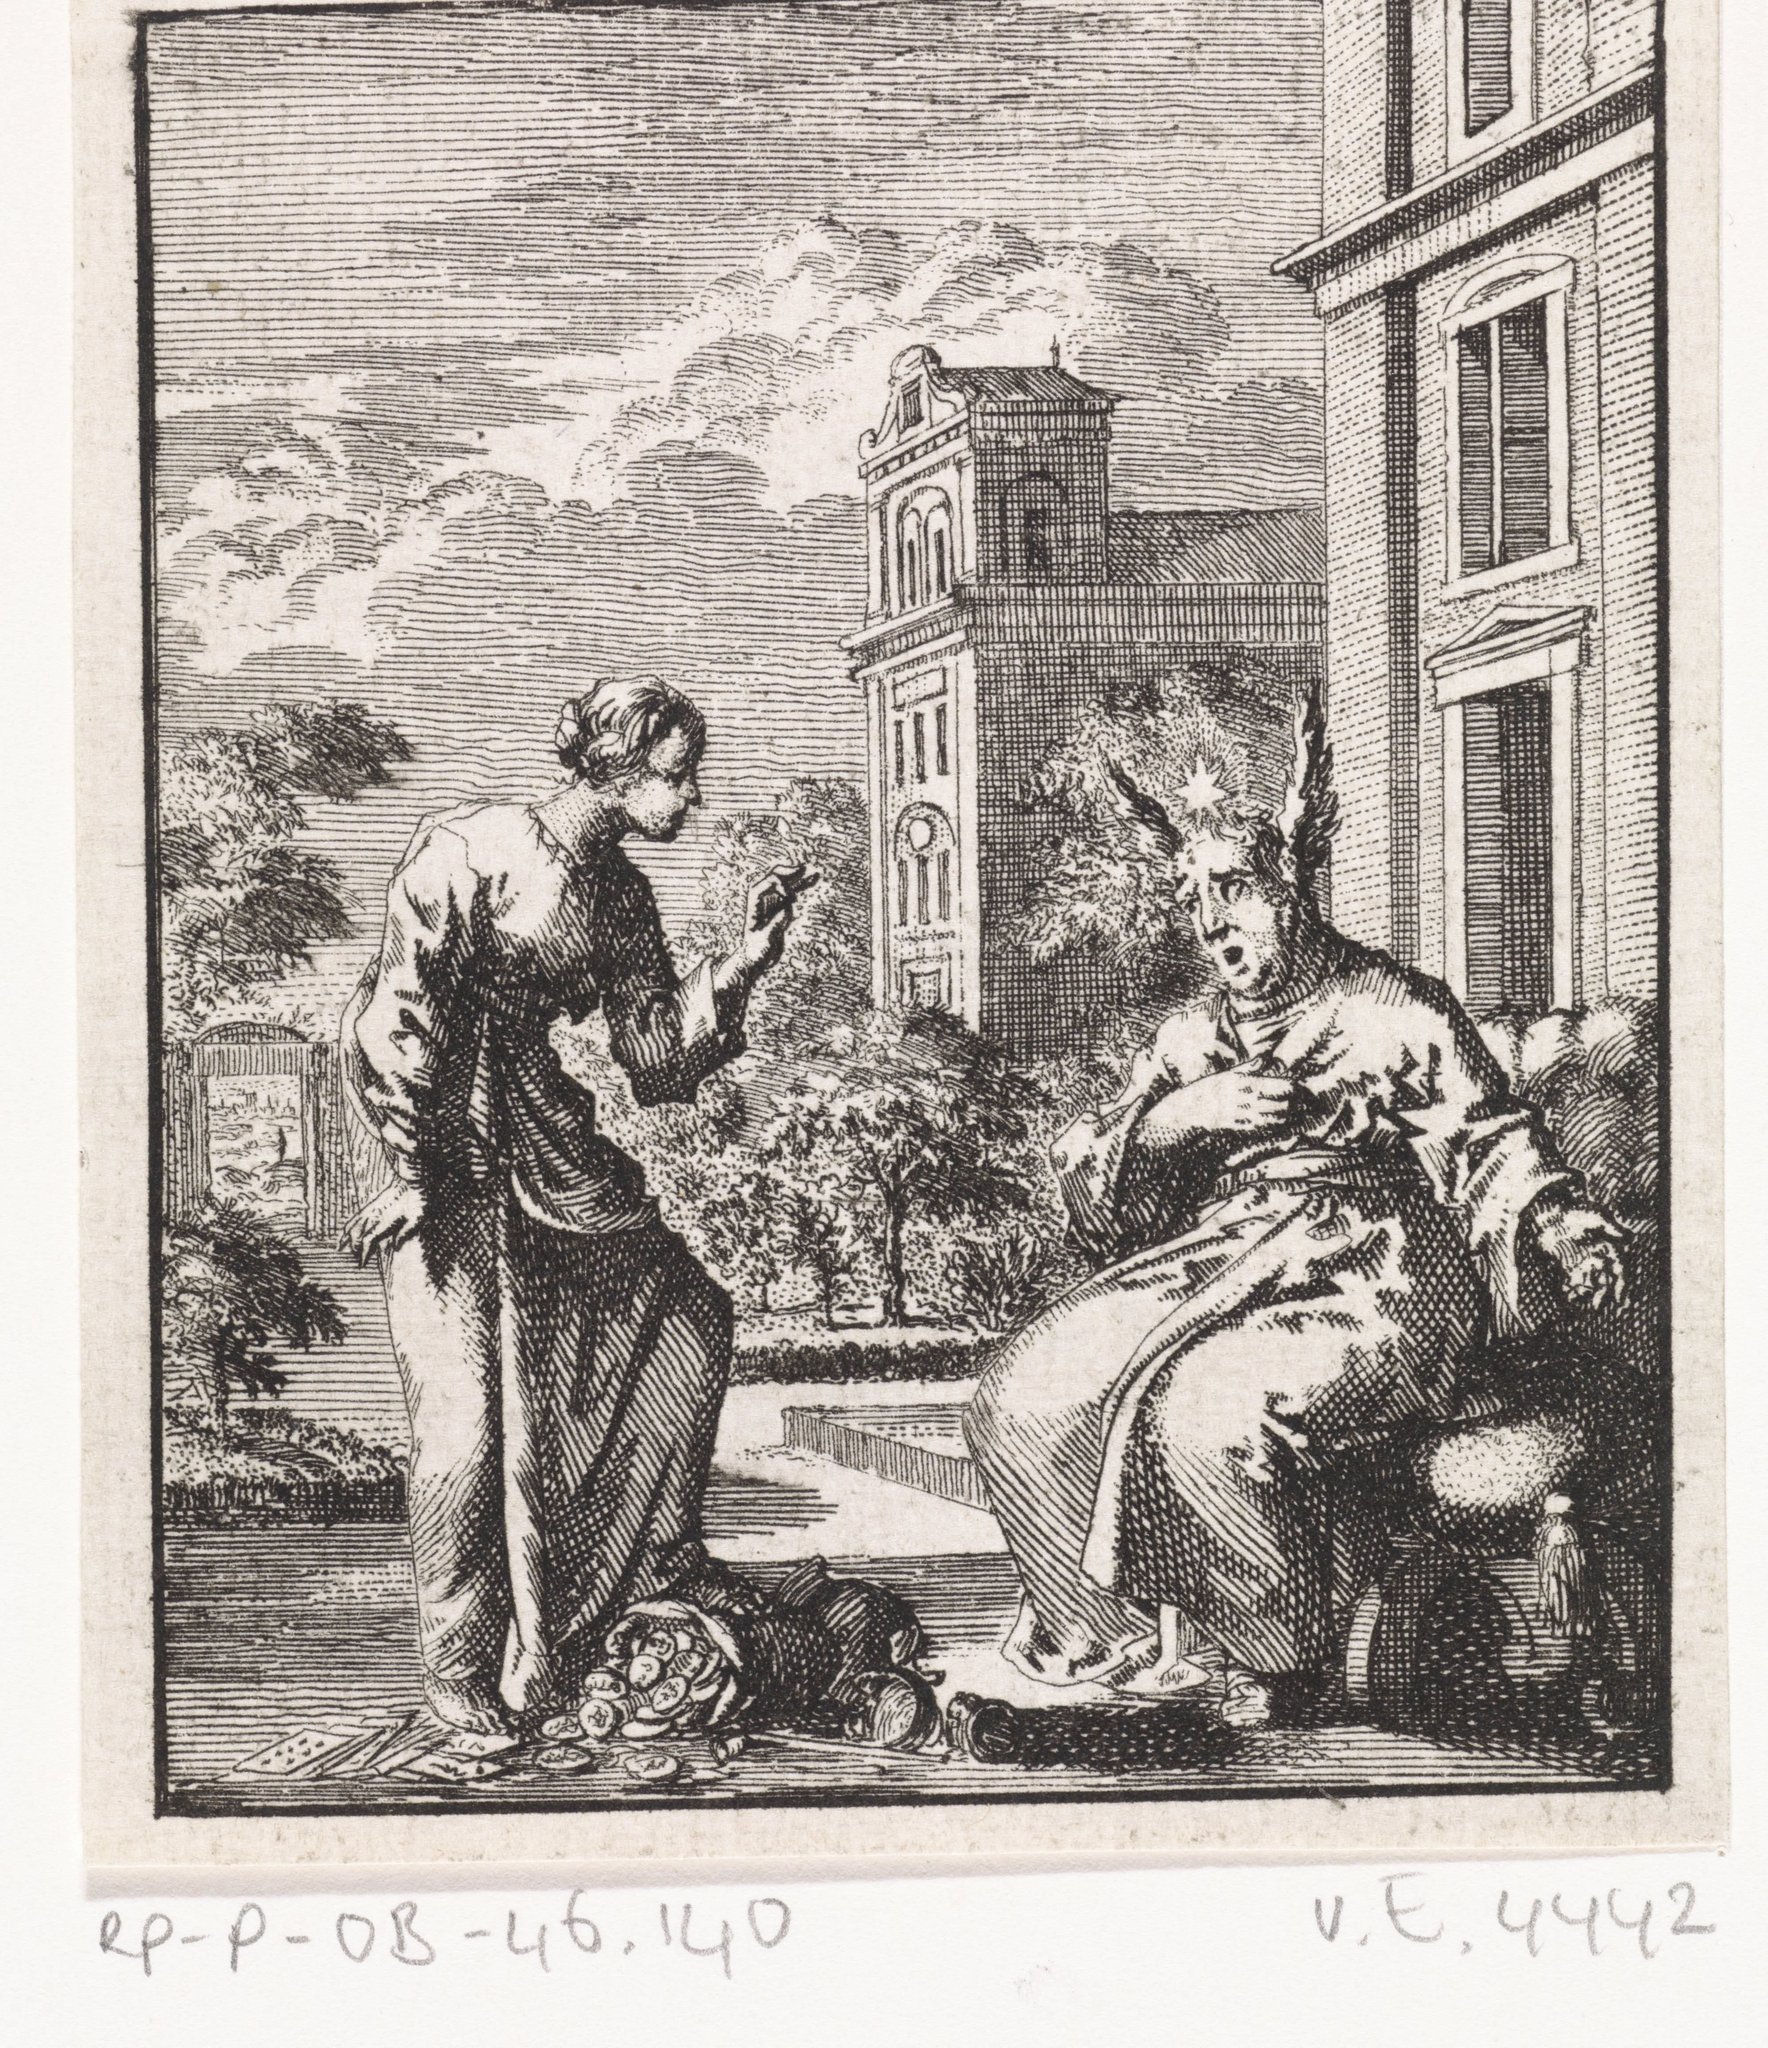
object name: print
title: Gepersonifieerde ziel spreekt het Vlees tegen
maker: jan luyken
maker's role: draughtsman, print maker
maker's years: 1649-1712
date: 1714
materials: paper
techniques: etching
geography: amsterdam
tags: spirit (or soul) versus body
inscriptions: collector's mark: Lugt 2228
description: De gepersonifieerde ziel spreekt de personificatie van het Vlees (wereldse verlokkingen) tegen. Onder haar voeten liggen spelkaarten, een stokkenbeurs, munten en andere voorwerpen die symbool staan voor een zondig leven.